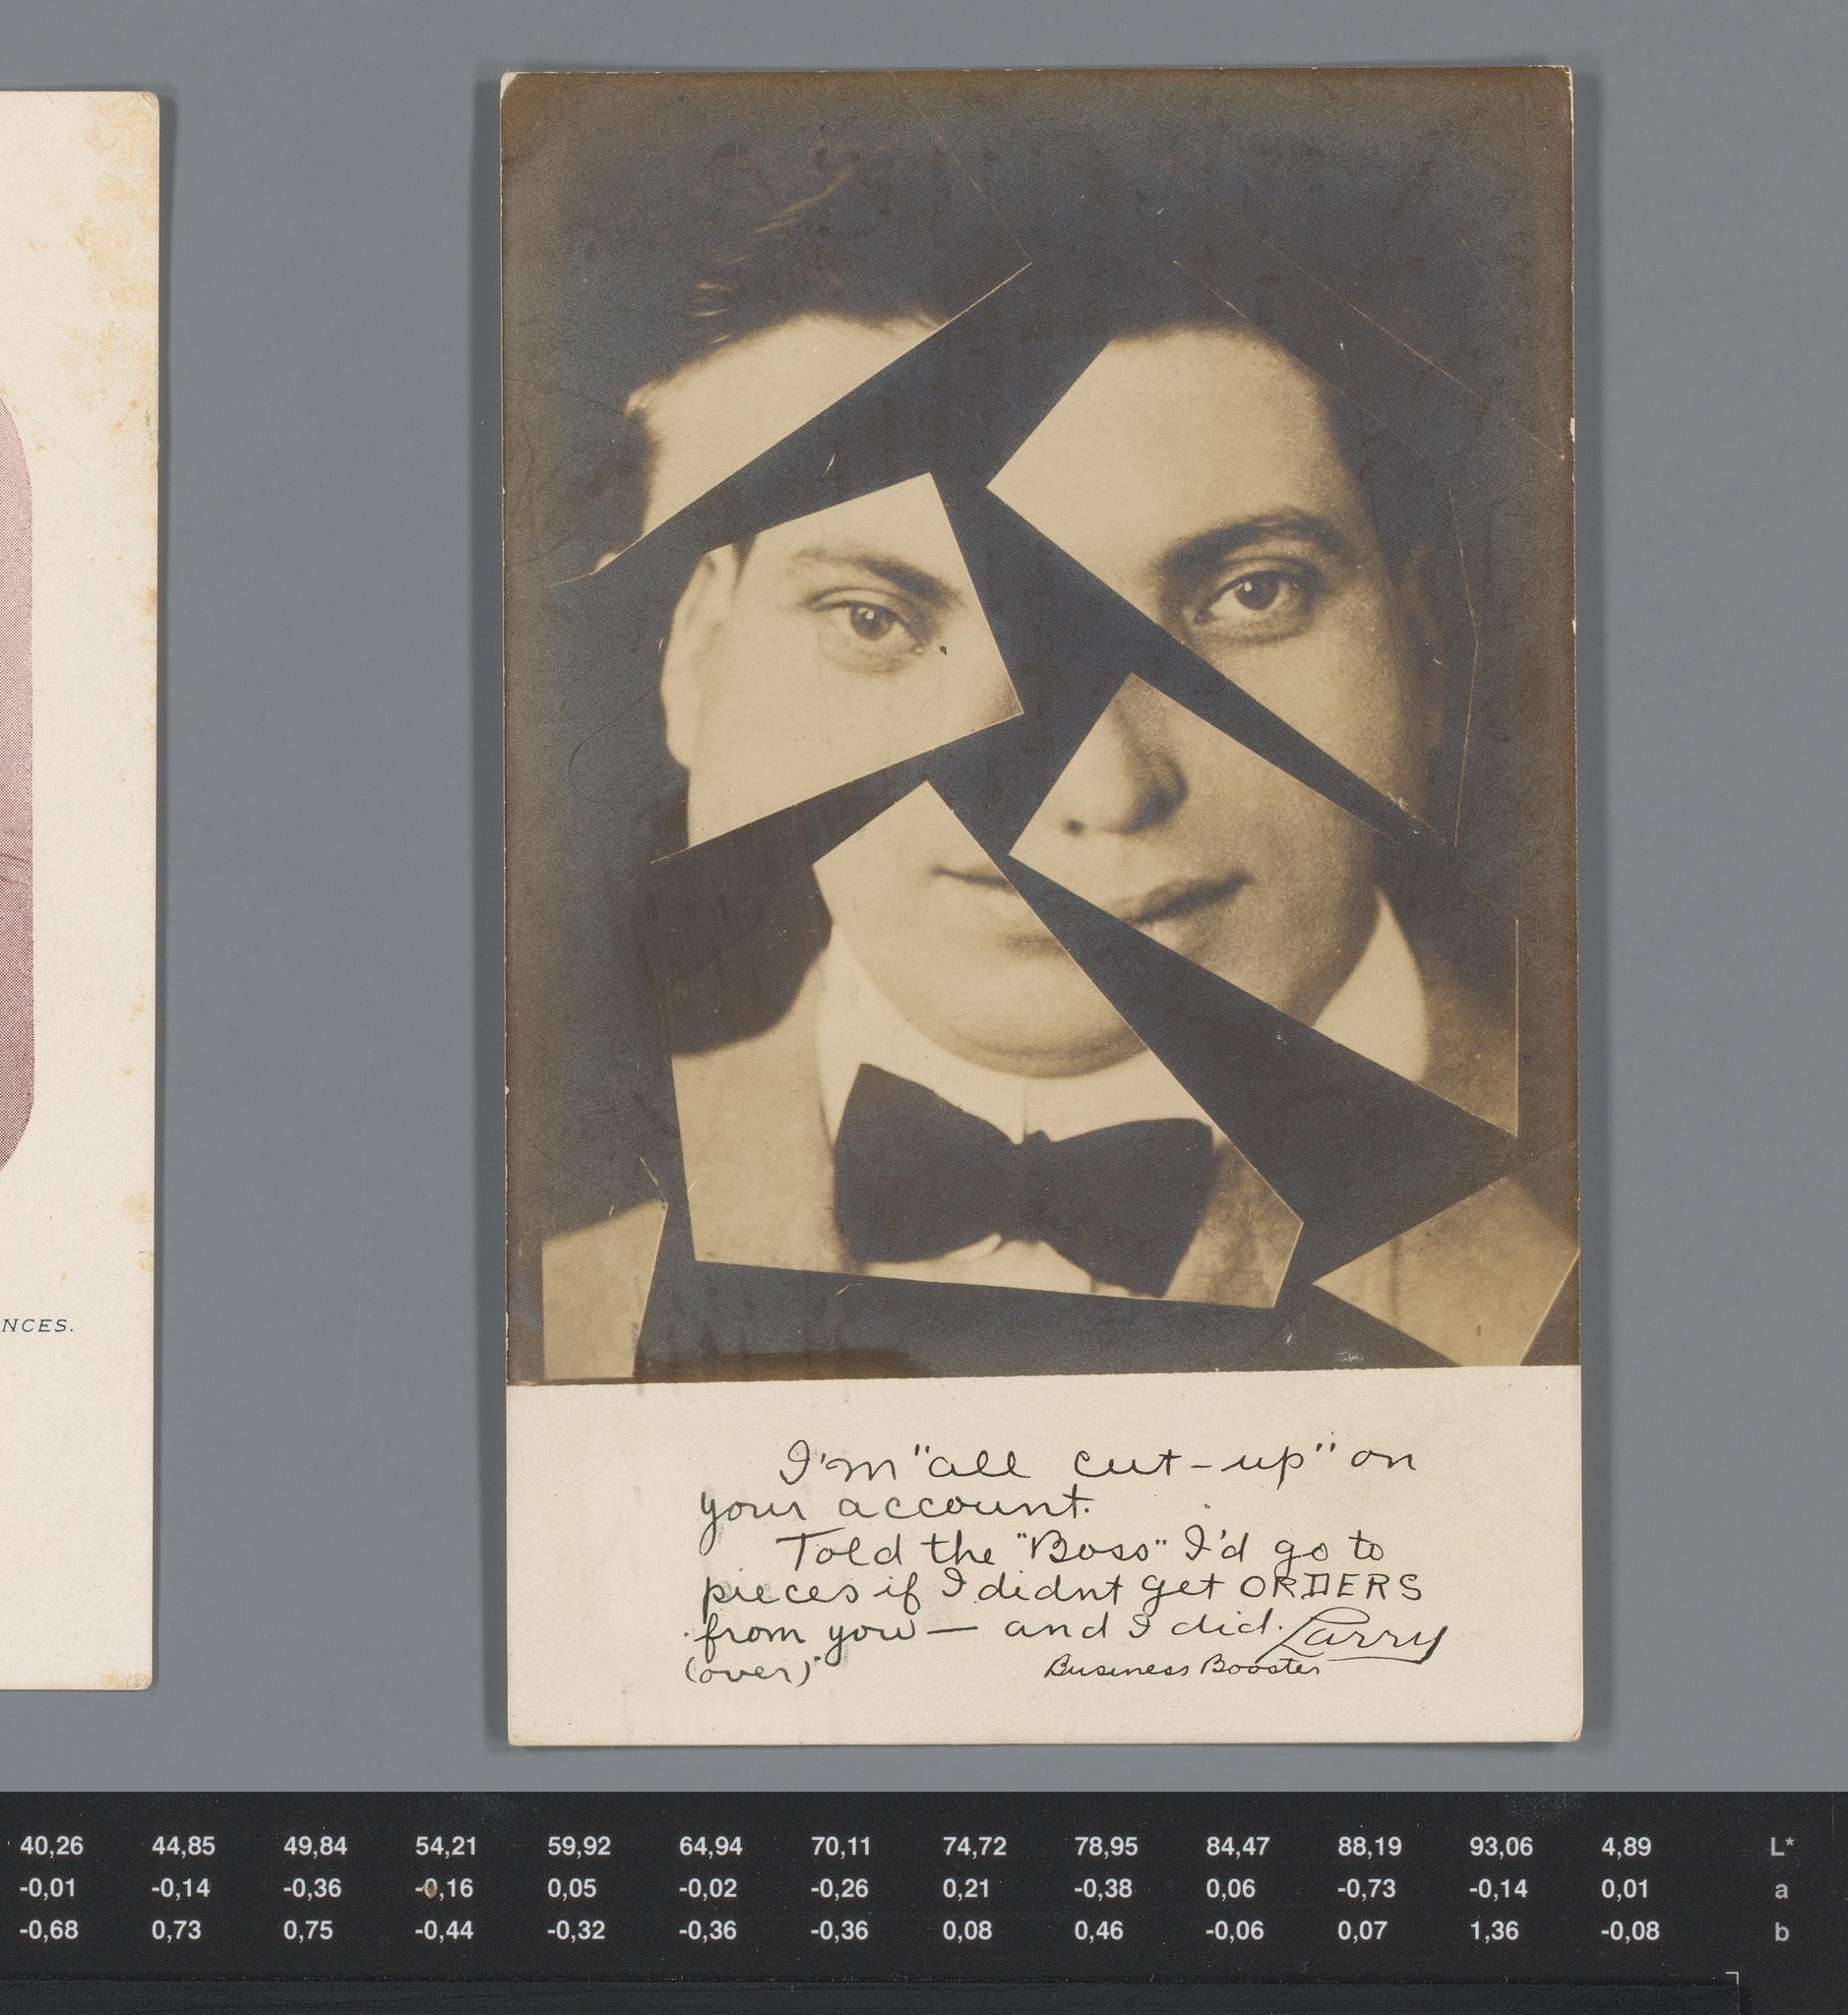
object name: photograph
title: Portret van een onbekende man in stukken geknipt als reclame voor Kahn Bros kleermakers in Louisville, Verenigde Staten van Amerika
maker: Anonymous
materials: paper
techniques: gelatin silver print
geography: louisville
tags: montage, cutting ~ film, historical persons not known by name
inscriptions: mark: ‘Kahn Bros Louisville/ tailors that satisfy’, inscription: ‘I'm "all cut-up" on/ your account./ Told the "Boss" I'd go to/ pieces if I didnt get ORDERS/ from you - and I did./ (over) Larry/ Business Booster’, : ‘Louisville, KY./ OCT 13/ 7 30 PM/ 1911’